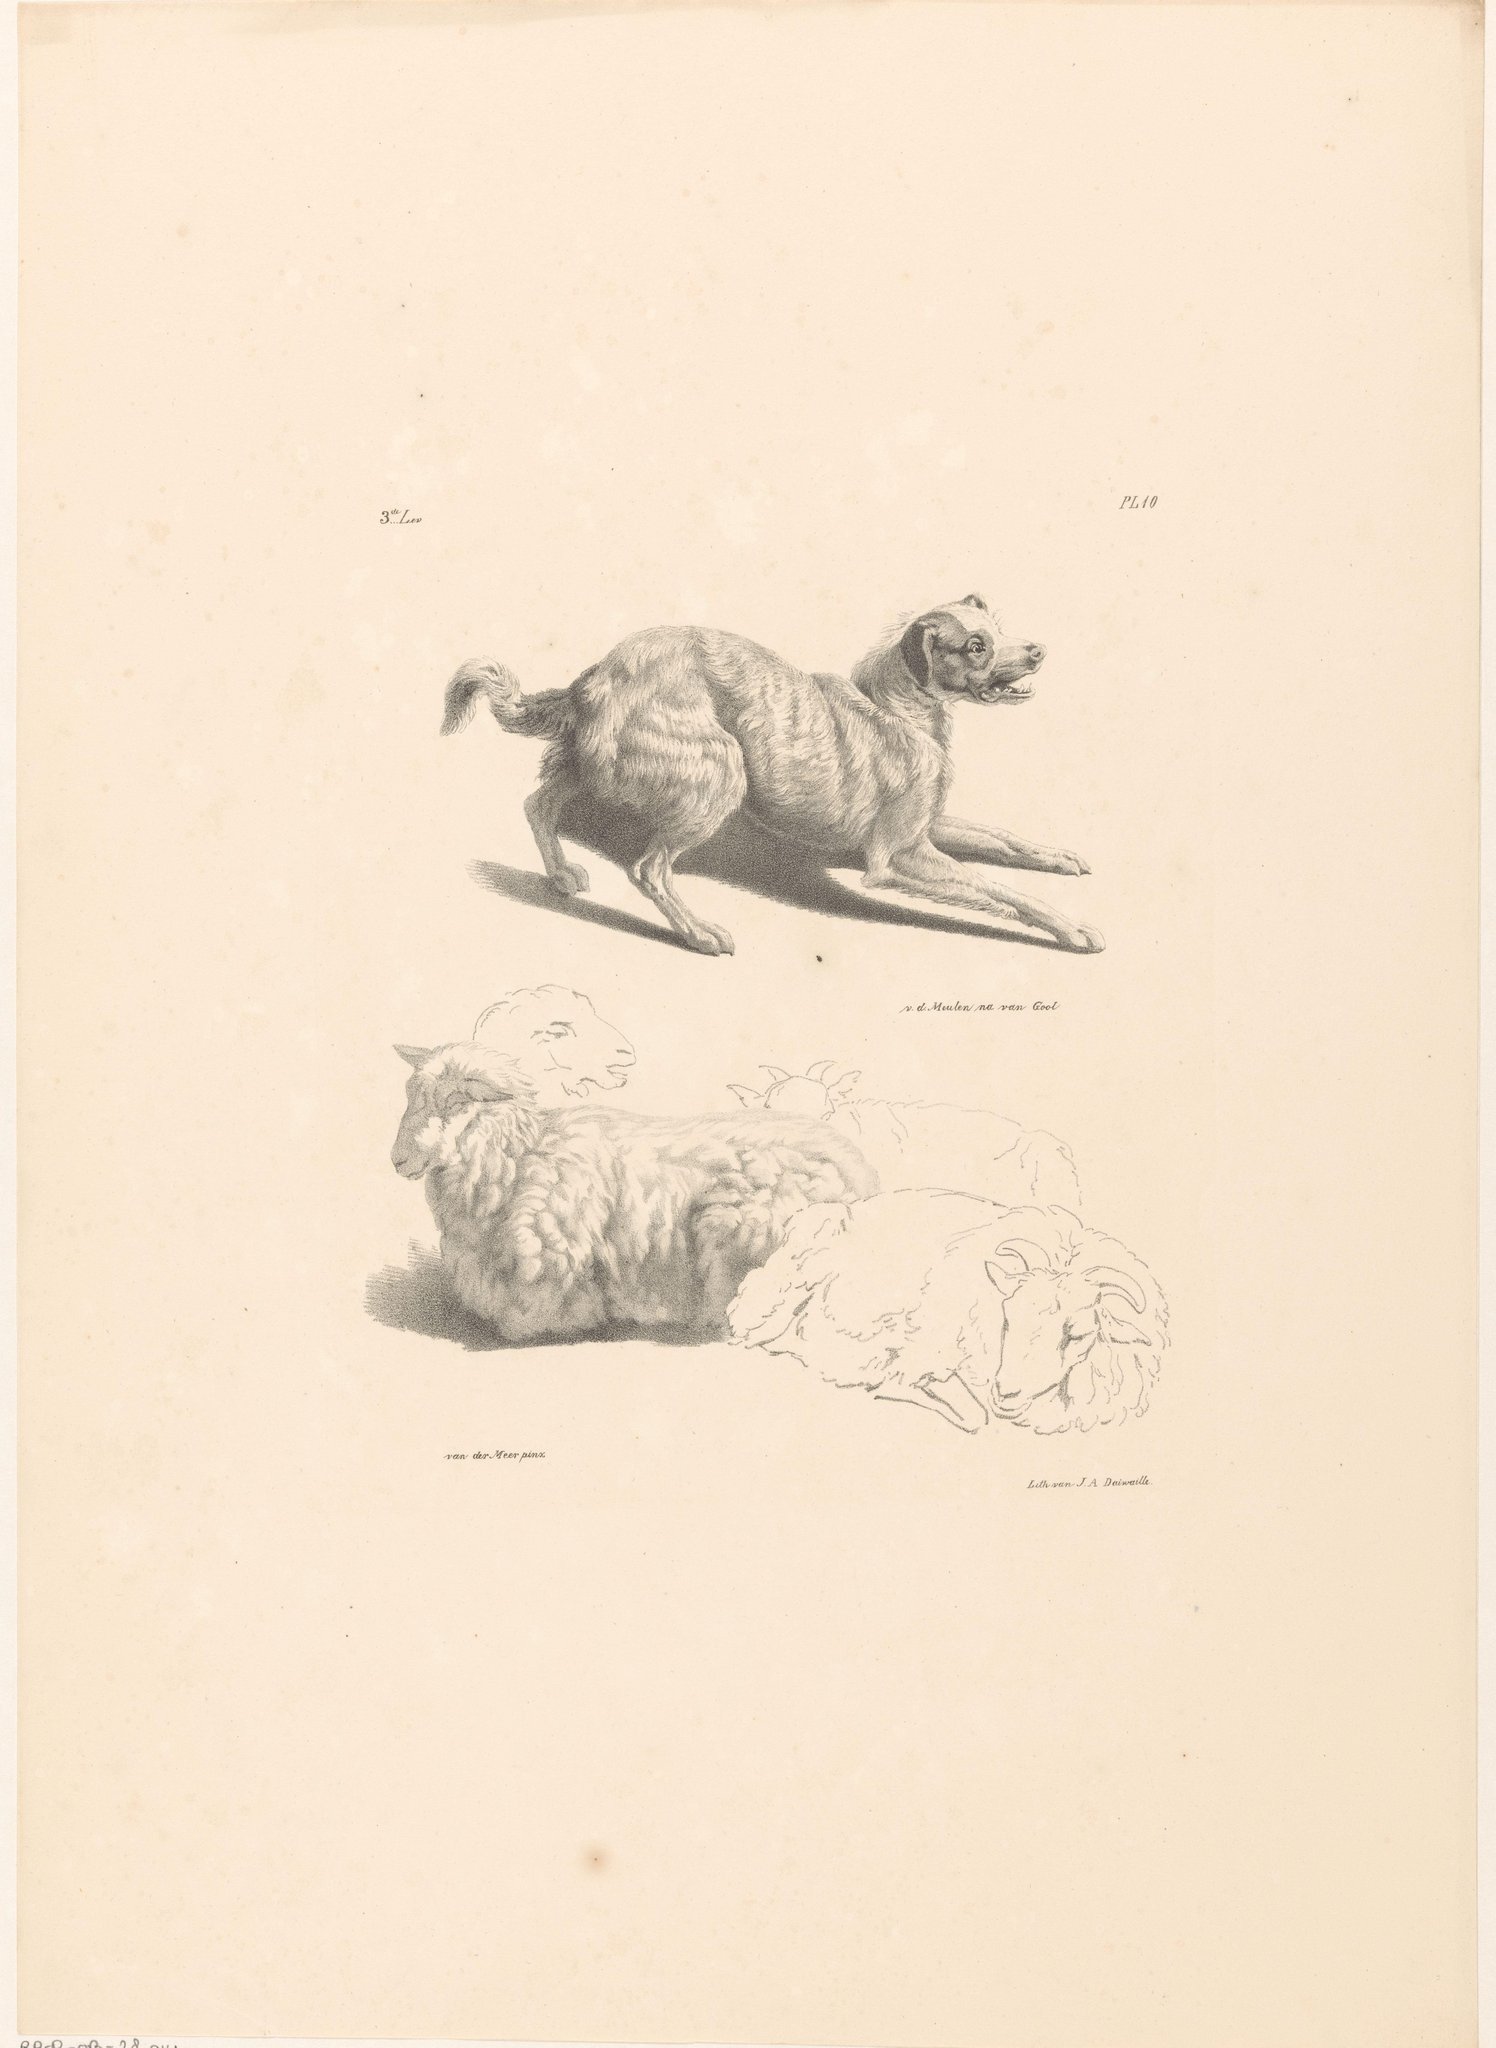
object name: print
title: Hond en schapen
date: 1820-1833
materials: paper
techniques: lithograph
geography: amsterdam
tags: sheep, dog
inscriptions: collector's mark: Lugt 2228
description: De hond staat door zijn voorpoten gezakt en heeft zijn bek open gesperd. Daaronder liggen vier schapen waarvan er een tot in de details is uitgewerkt. De hond is naar Jan van Gool, de schapen naar Jan van der Meer. Genummerd rechtsboven: 'Pl. 10' en linksboven: '3de..Lev'